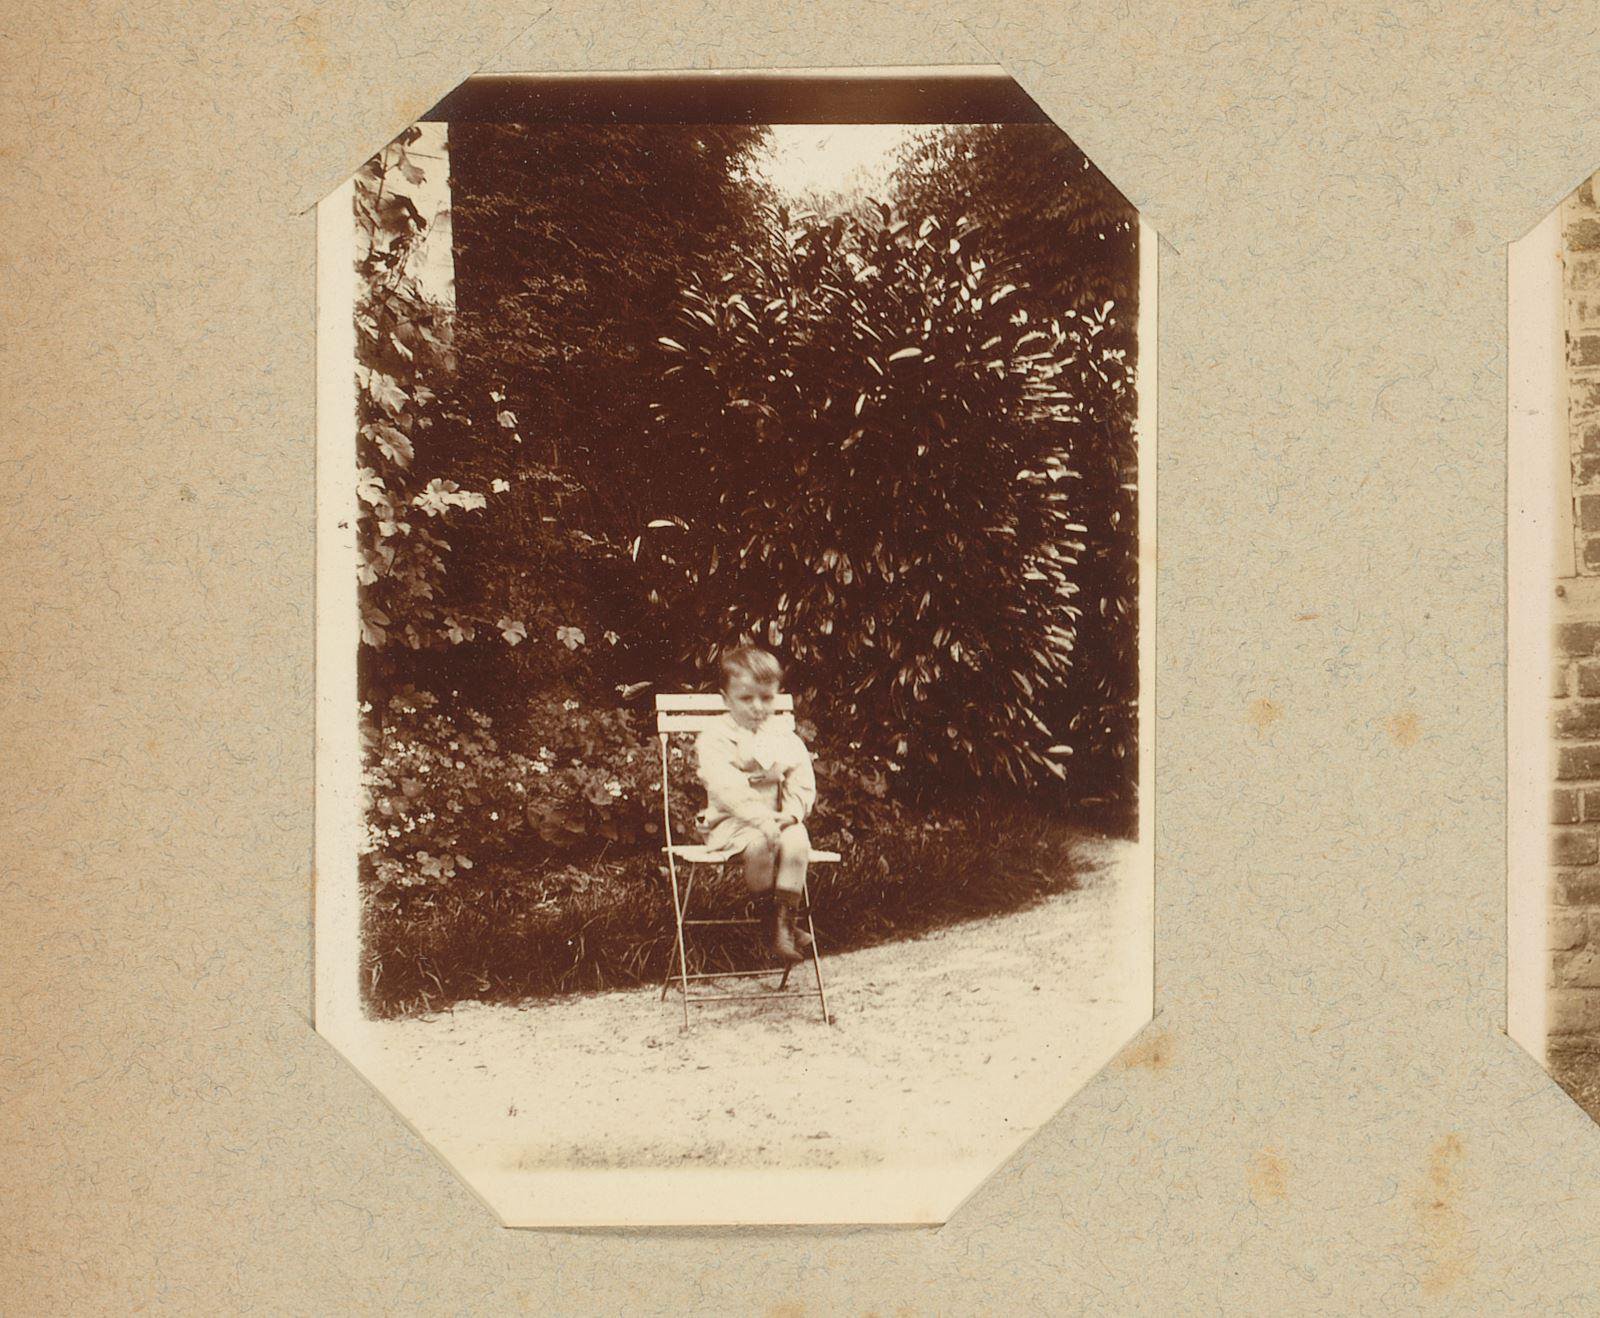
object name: photograph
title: Portret van een jongen op een stoel in tuin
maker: Anonymous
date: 1897-1900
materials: paper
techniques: gelatin silver print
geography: france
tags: boy (child between toddler and youth), garden, historical persons, france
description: Over de foto is een ander negatief afgedrukt van een voorstelling van bomen.